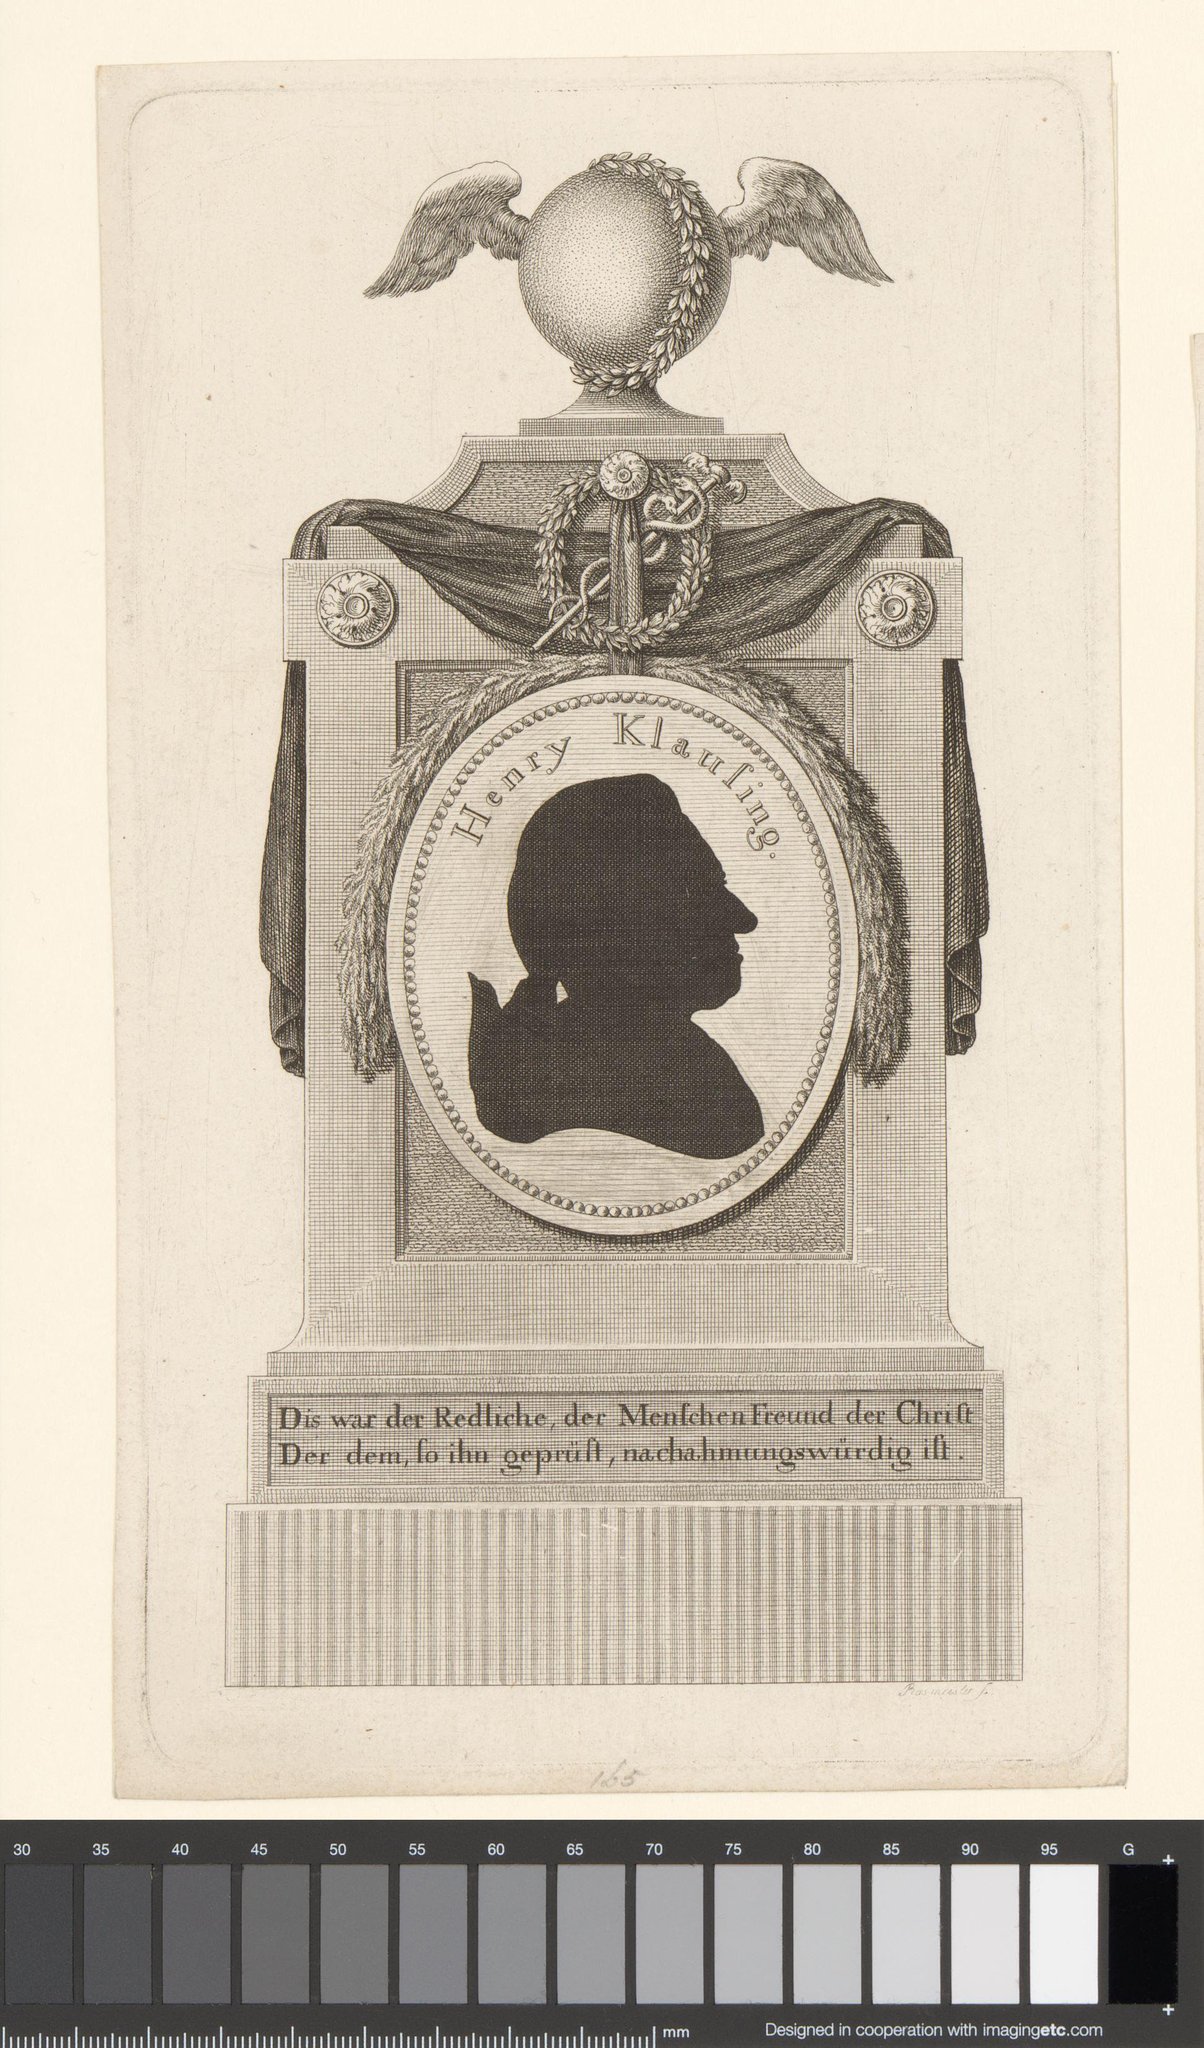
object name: print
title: Silhouetportret van Heinrich Klausing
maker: friedrich rossmässler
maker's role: print maker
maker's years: 1775-1858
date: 1785-1858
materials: paper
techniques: engraving, etching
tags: sphere, globe ~ stereometry, historical persons, other allegories of time, e.g. 'tempo' (ripa), caduceus (staff with two snakes, attribute of mercury)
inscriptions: collector's mark: Lugt 2228